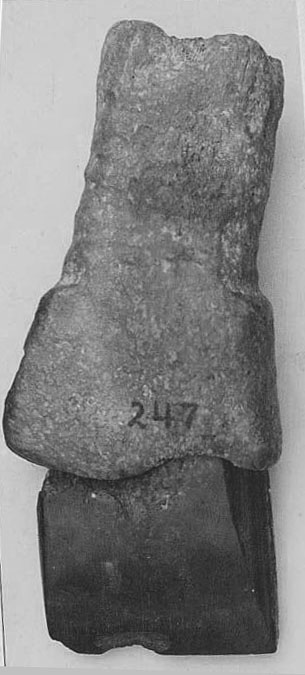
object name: adze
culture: north american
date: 1902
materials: jade